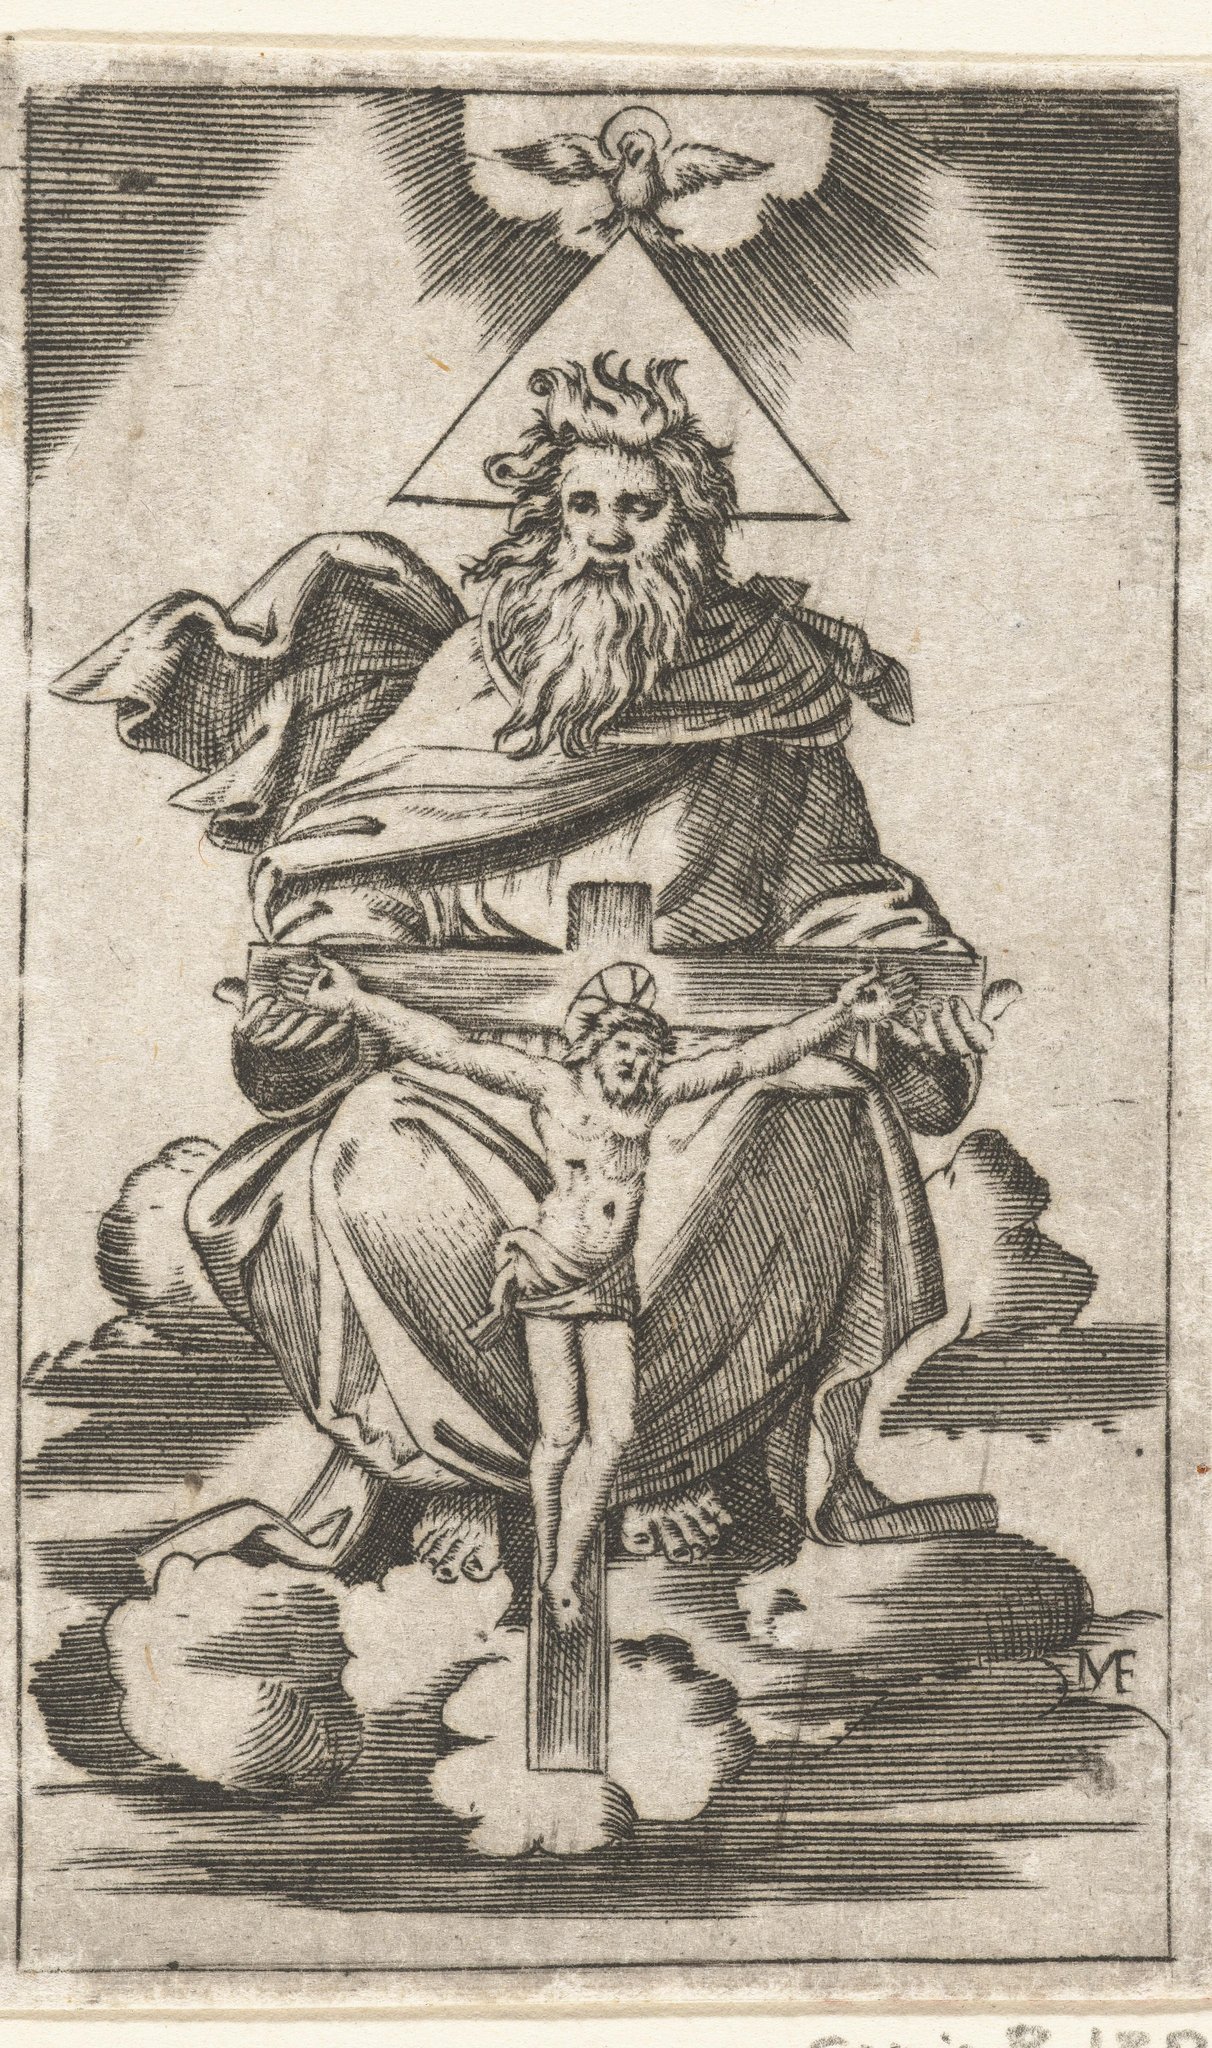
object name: print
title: Genadestoel met God de vader die crucifix vasthoudt en heilige Geest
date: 1500-1575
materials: paper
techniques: engraving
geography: italy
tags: god the father holding the crucifix, 'gnadenstuhl', mercy-seat, throne of grace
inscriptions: collector's mark: Lugt 12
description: Kopie naar prent van Marcantonio Raimondi.